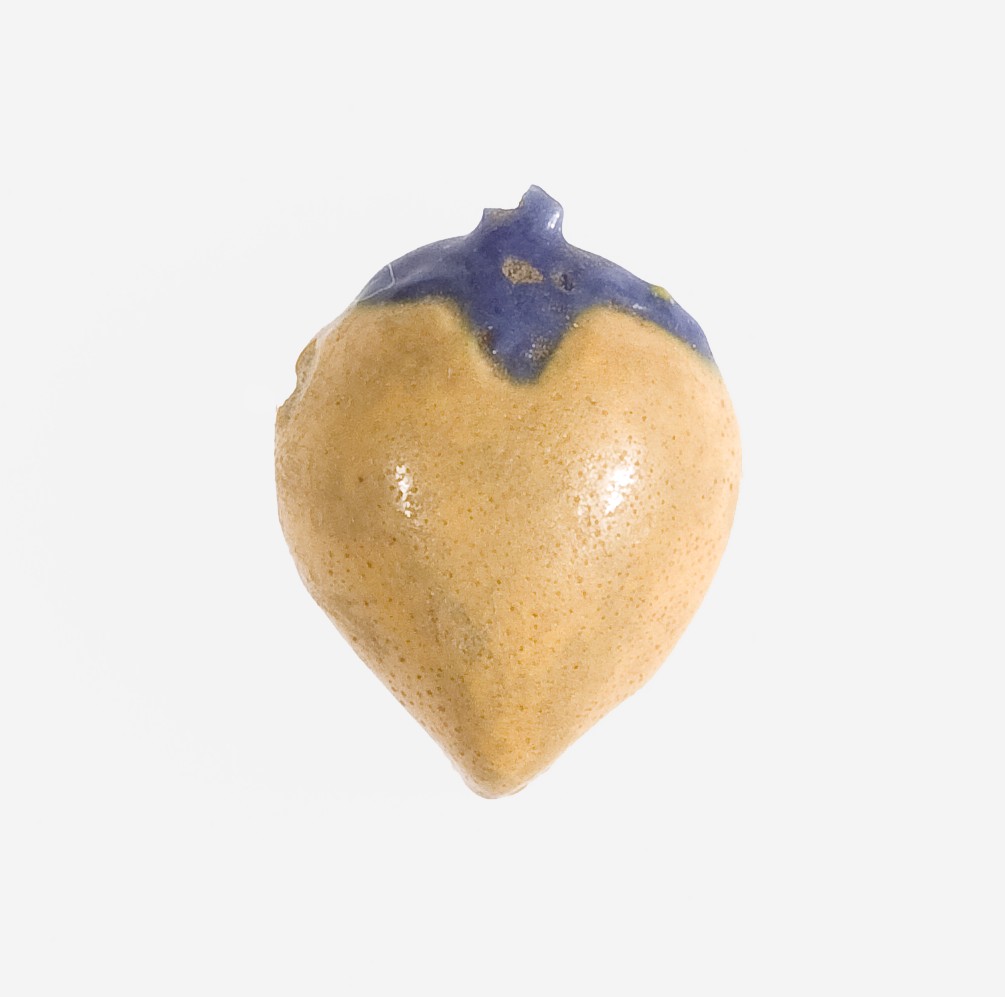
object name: pendant, persea fruit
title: Persea fruit pendant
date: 1390-1352 BCE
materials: faience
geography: egypt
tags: fruit